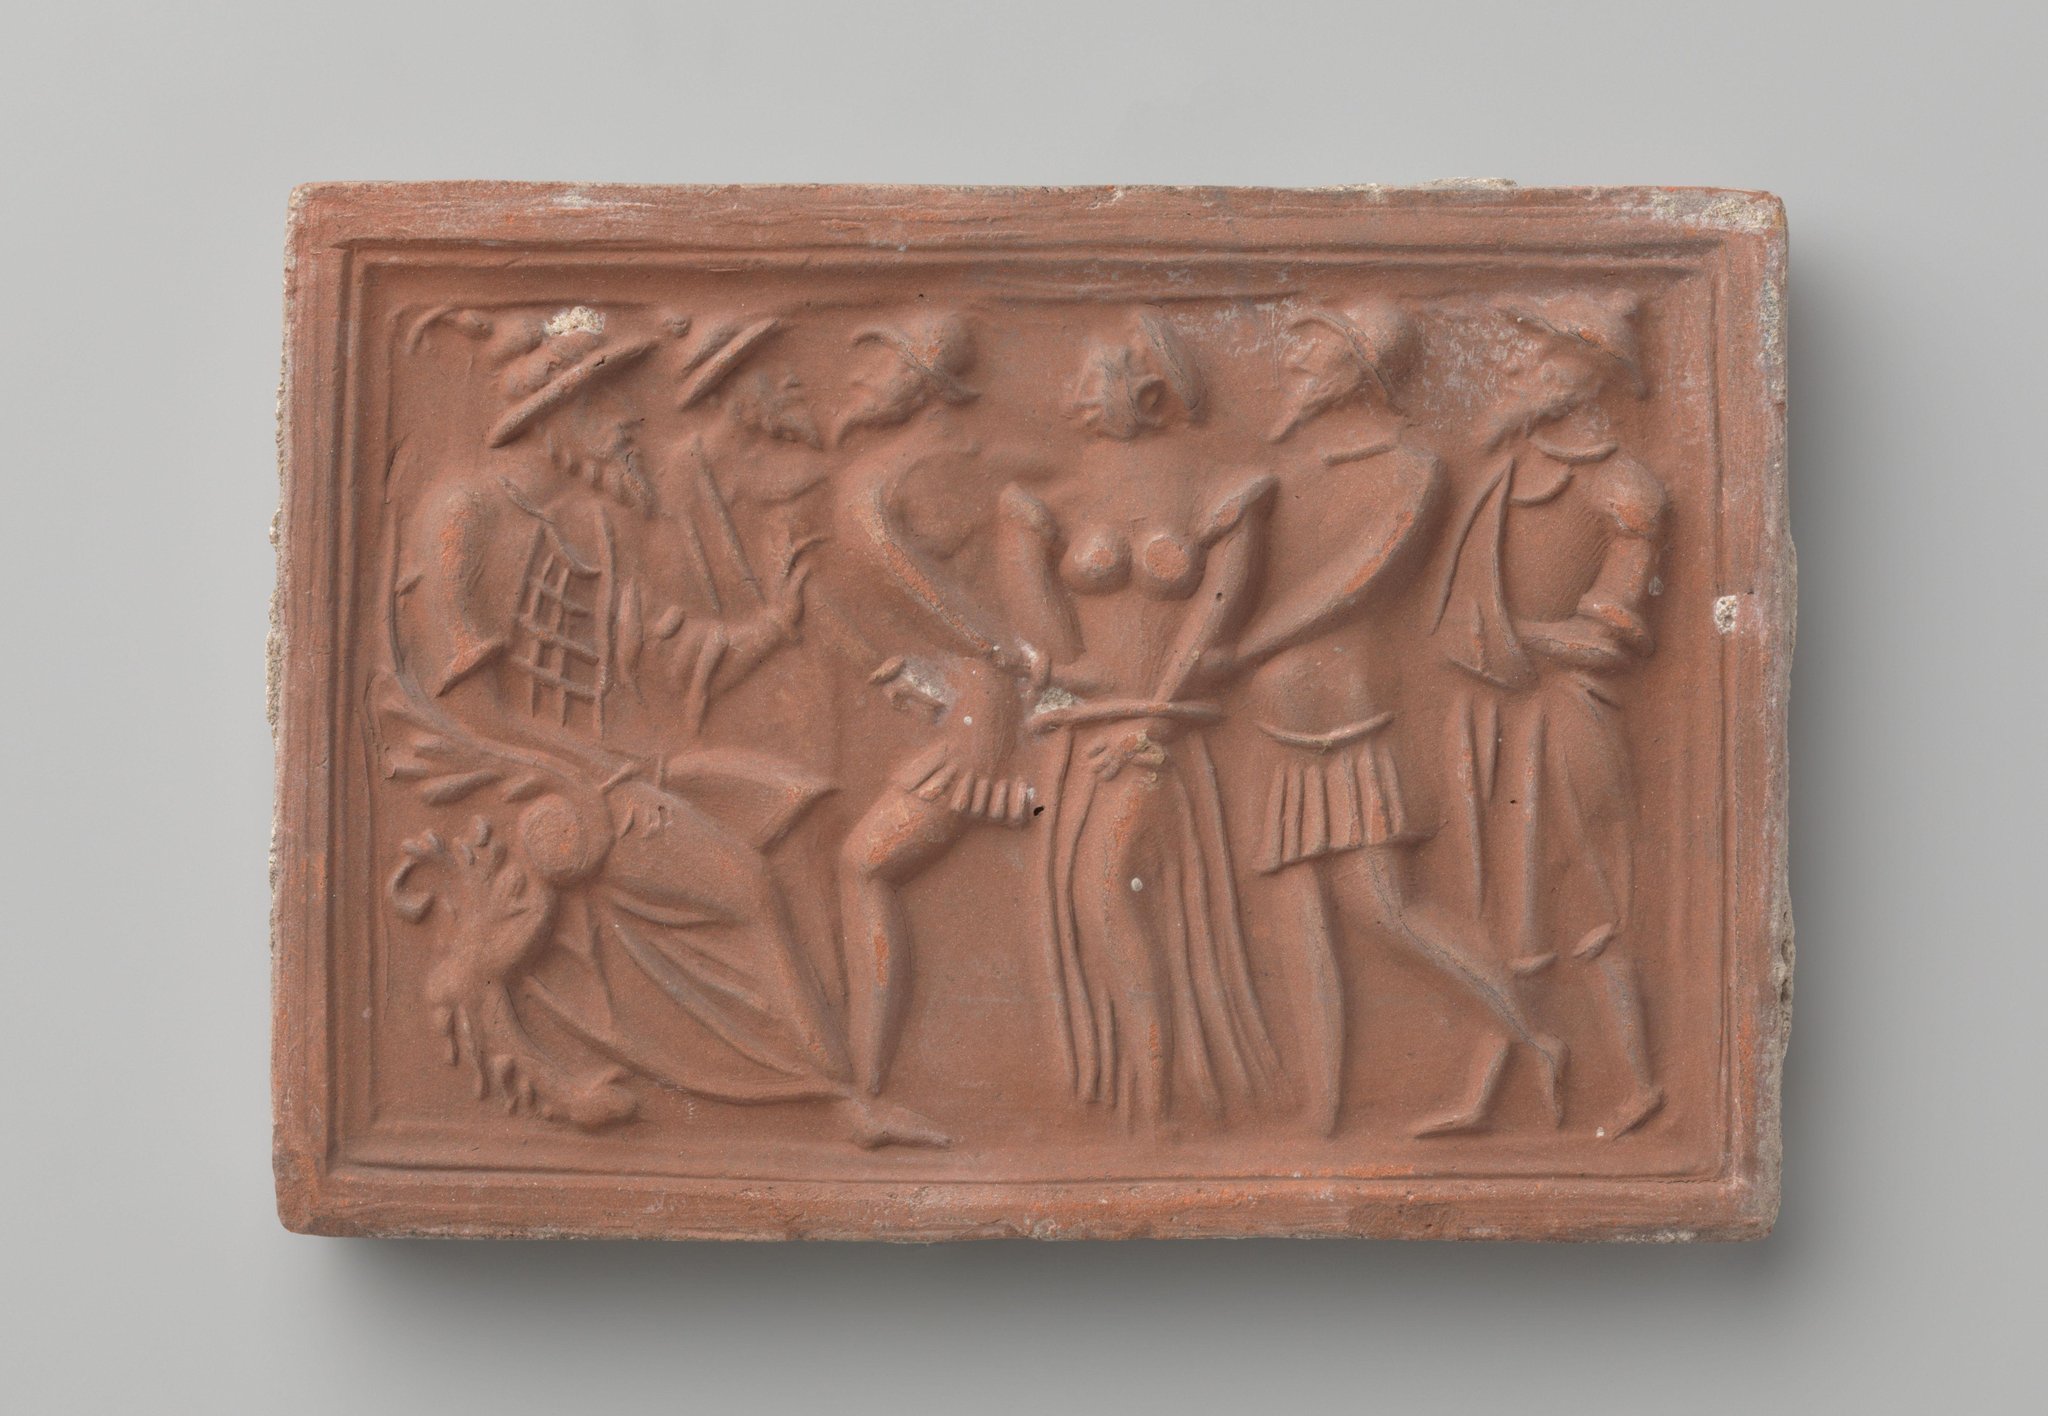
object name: hearthstone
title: Haardsteen met voorstelling van Suzanna, die door de twee ouderlingen voor de rechter wordt gevoerd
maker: Anonymous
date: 1875-1900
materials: earthenware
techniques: printing, firing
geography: netherlands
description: Haardsteen met voorstelling van Suzanna, die door de twee ouderlingen voor de rechter wordt gevoerd. De zetel van de rechter staat heraldisch rechts.